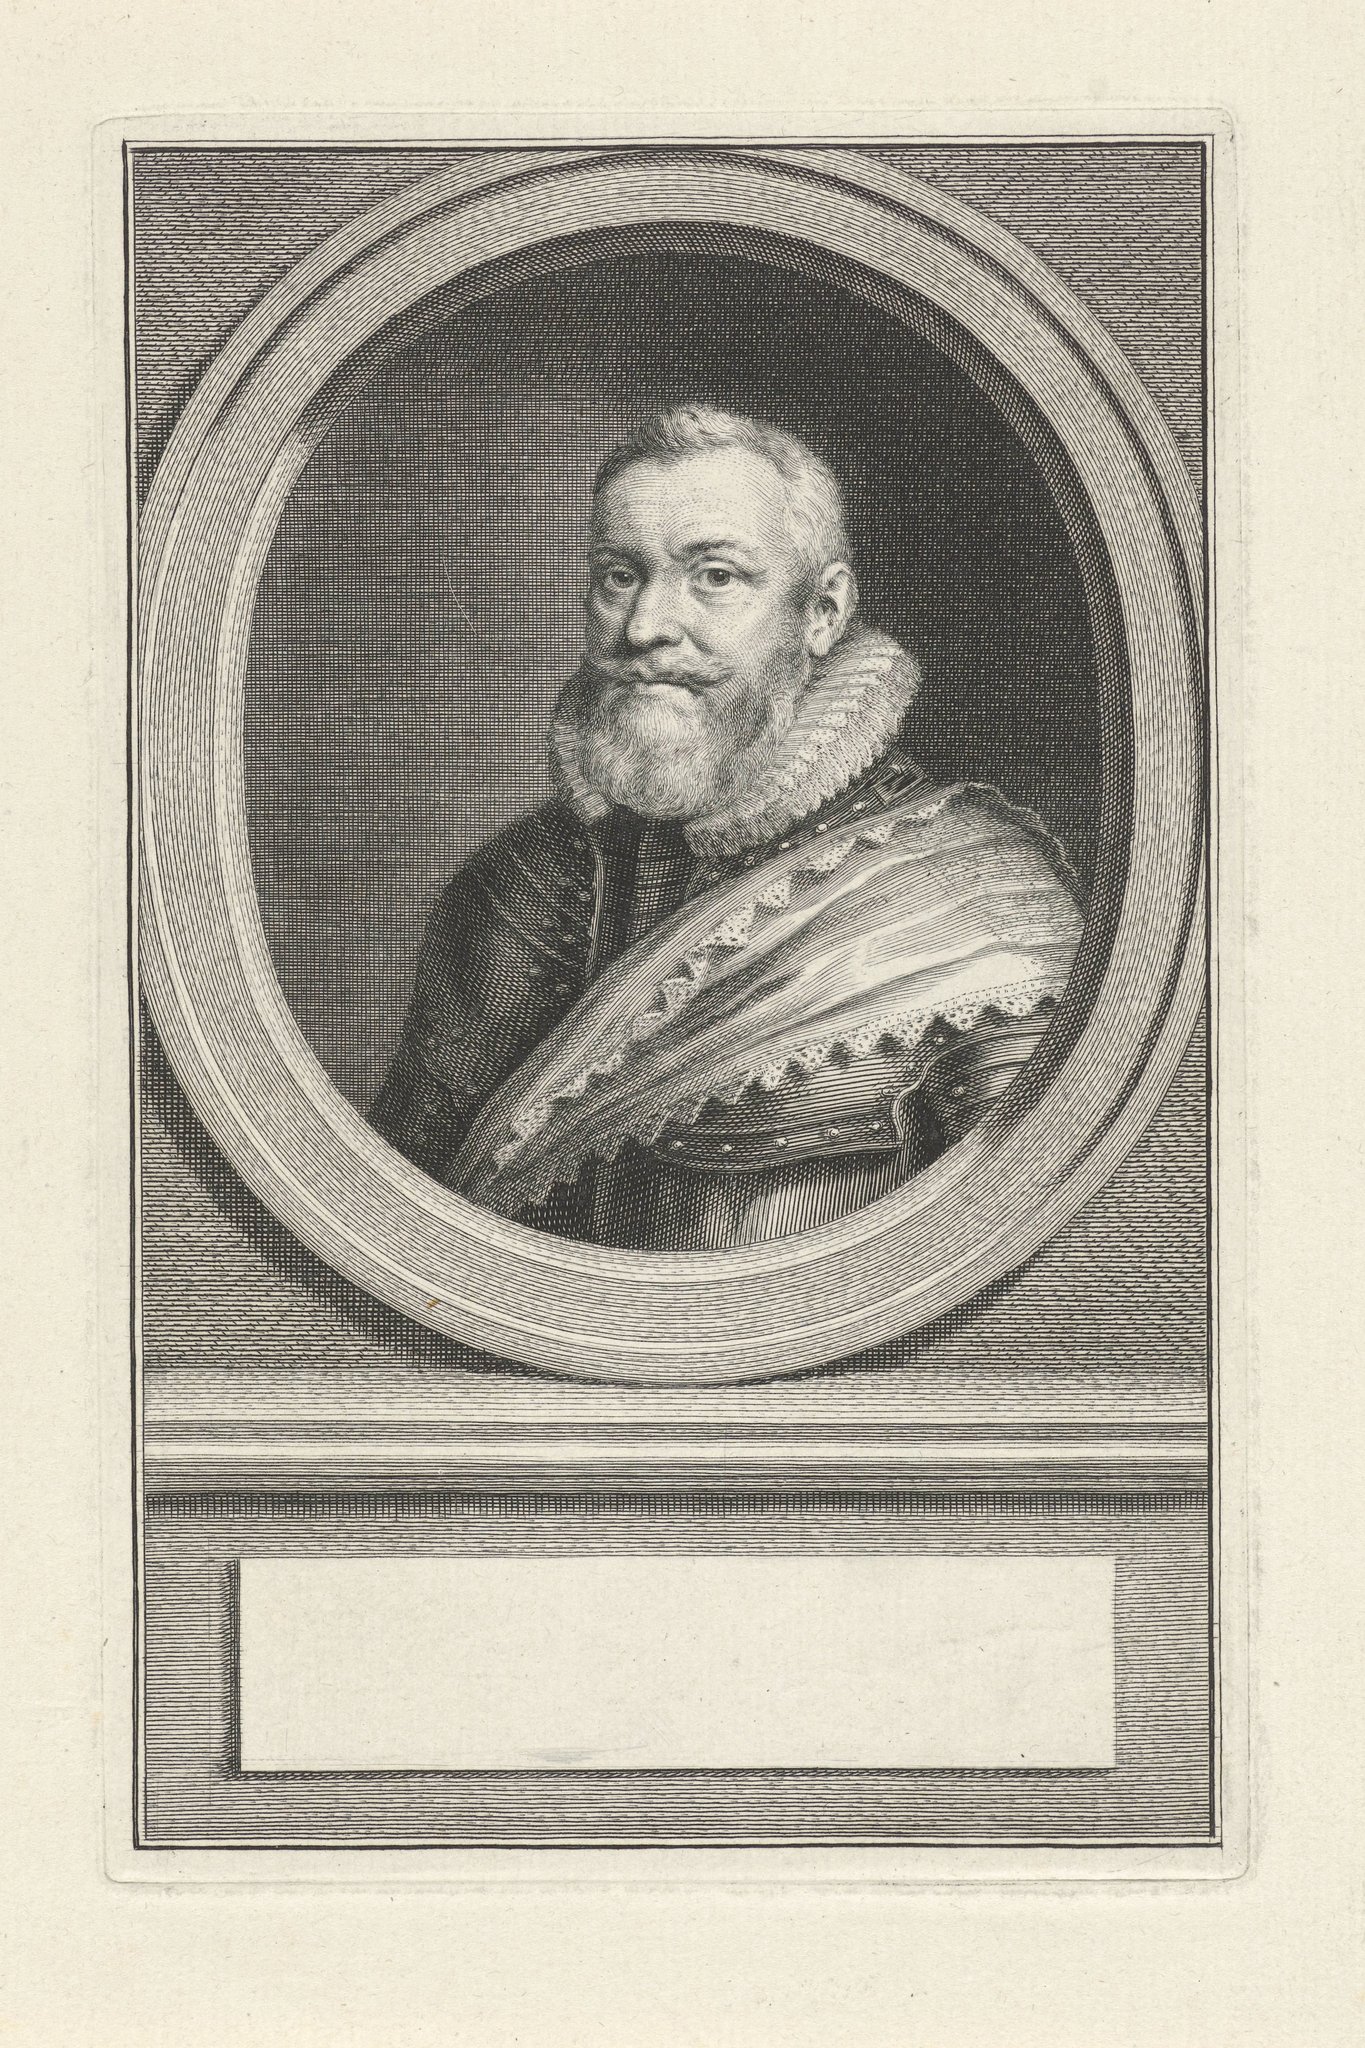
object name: print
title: Portret van Willem Lodewijk, graaf van Nassau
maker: jacob houbraken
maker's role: draughtsman, print maker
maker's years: 1698-1780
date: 1747-1759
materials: paper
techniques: engraving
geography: amsterdam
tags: willem lodewijk graaf van nassau-dillenburg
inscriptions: collector's mark: Lugt 240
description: Latere staat van de prent gebruikt in: Jan Wagenaar, Vaderlandsche historie, vervattende de geschiedenissen der nu Vereenigde Nederlanden, inzonderheid die van Holland (...), 21 delen. Amsterdam, Isaak Tirion, 1749-59.